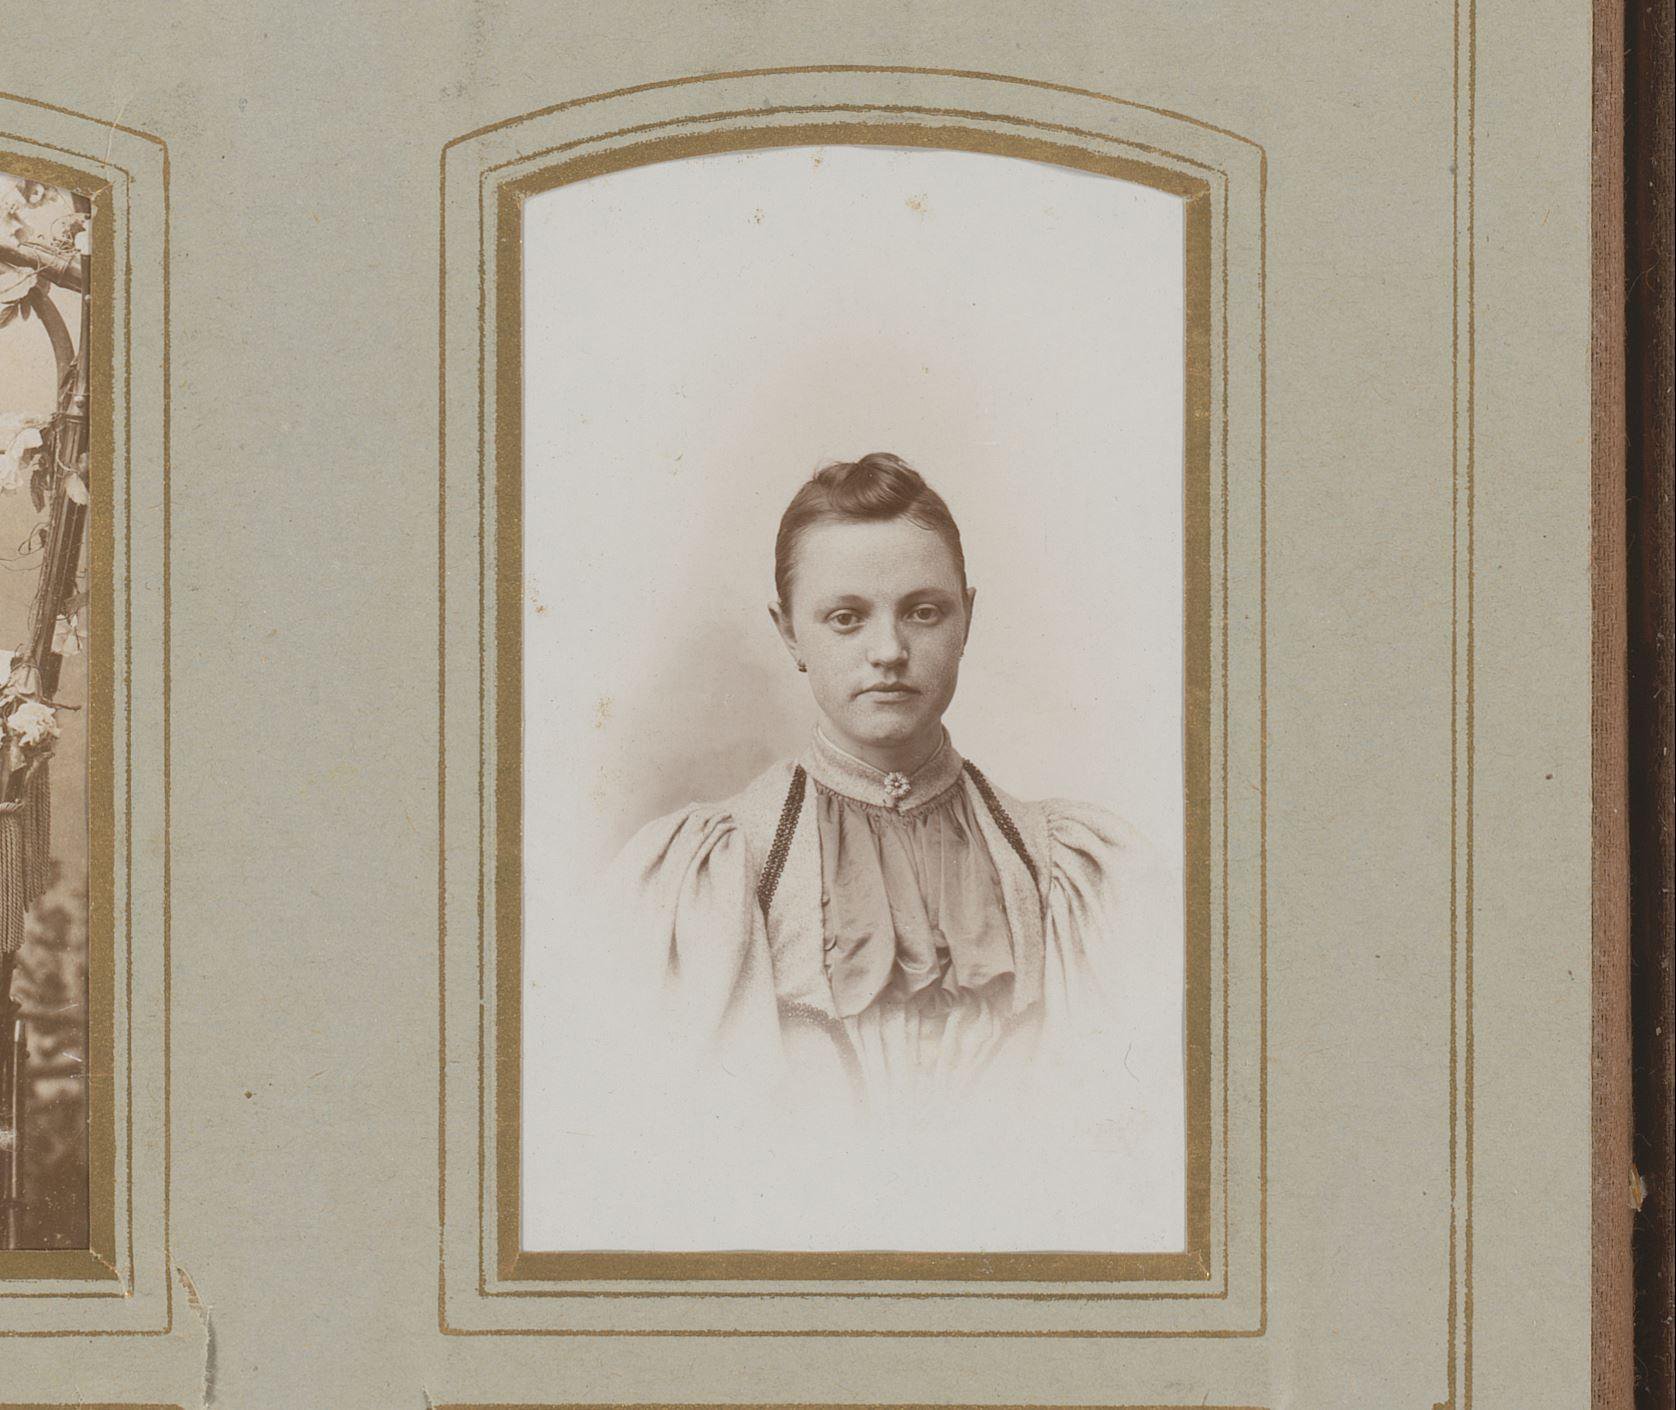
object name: photograph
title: Portret van een jonge vrouw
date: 1890-1918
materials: cardboard, photographic support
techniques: collodion silver print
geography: edam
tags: adolescent, young woman, maiden, historical persons - bb - woman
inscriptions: inscription: ‘Photographische/ Ateliers/ J. Siewers & Zoon/ Edam/ Hilversum./ Specialiteit in vergrootingen.’